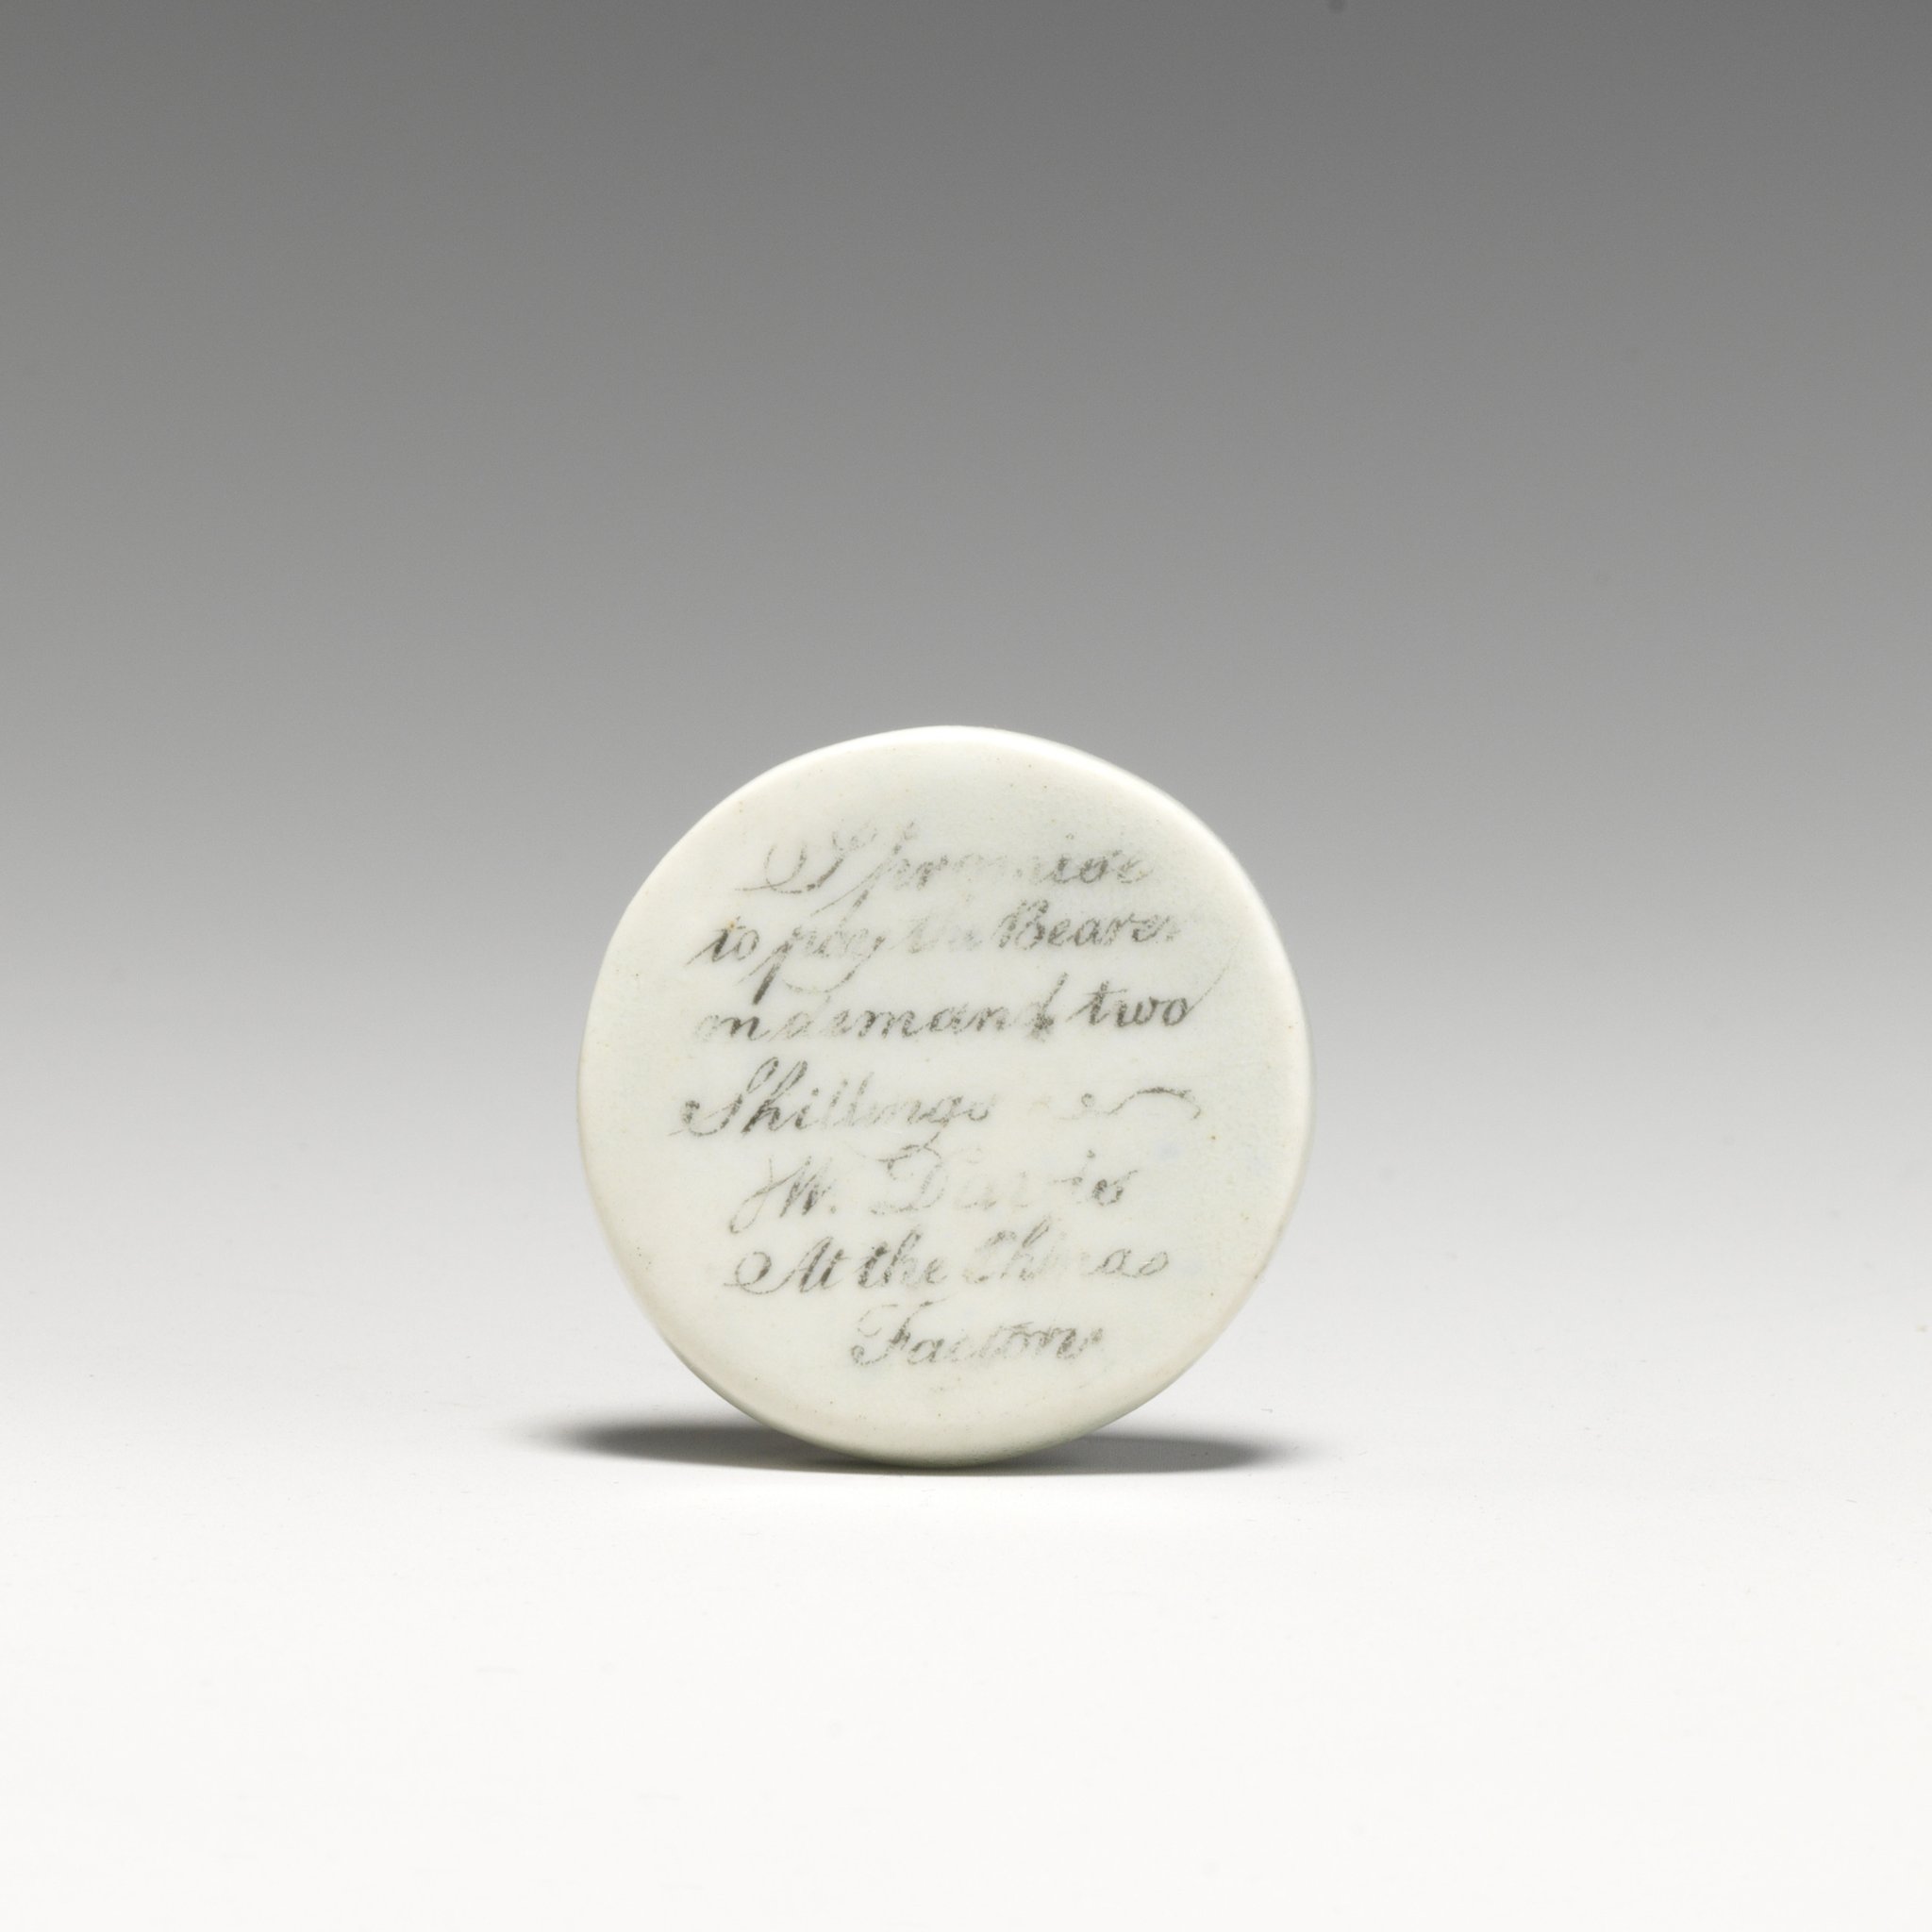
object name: token money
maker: worcester factory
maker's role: artist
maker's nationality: british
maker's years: 1751-2008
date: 1780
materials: soft paste porcelain